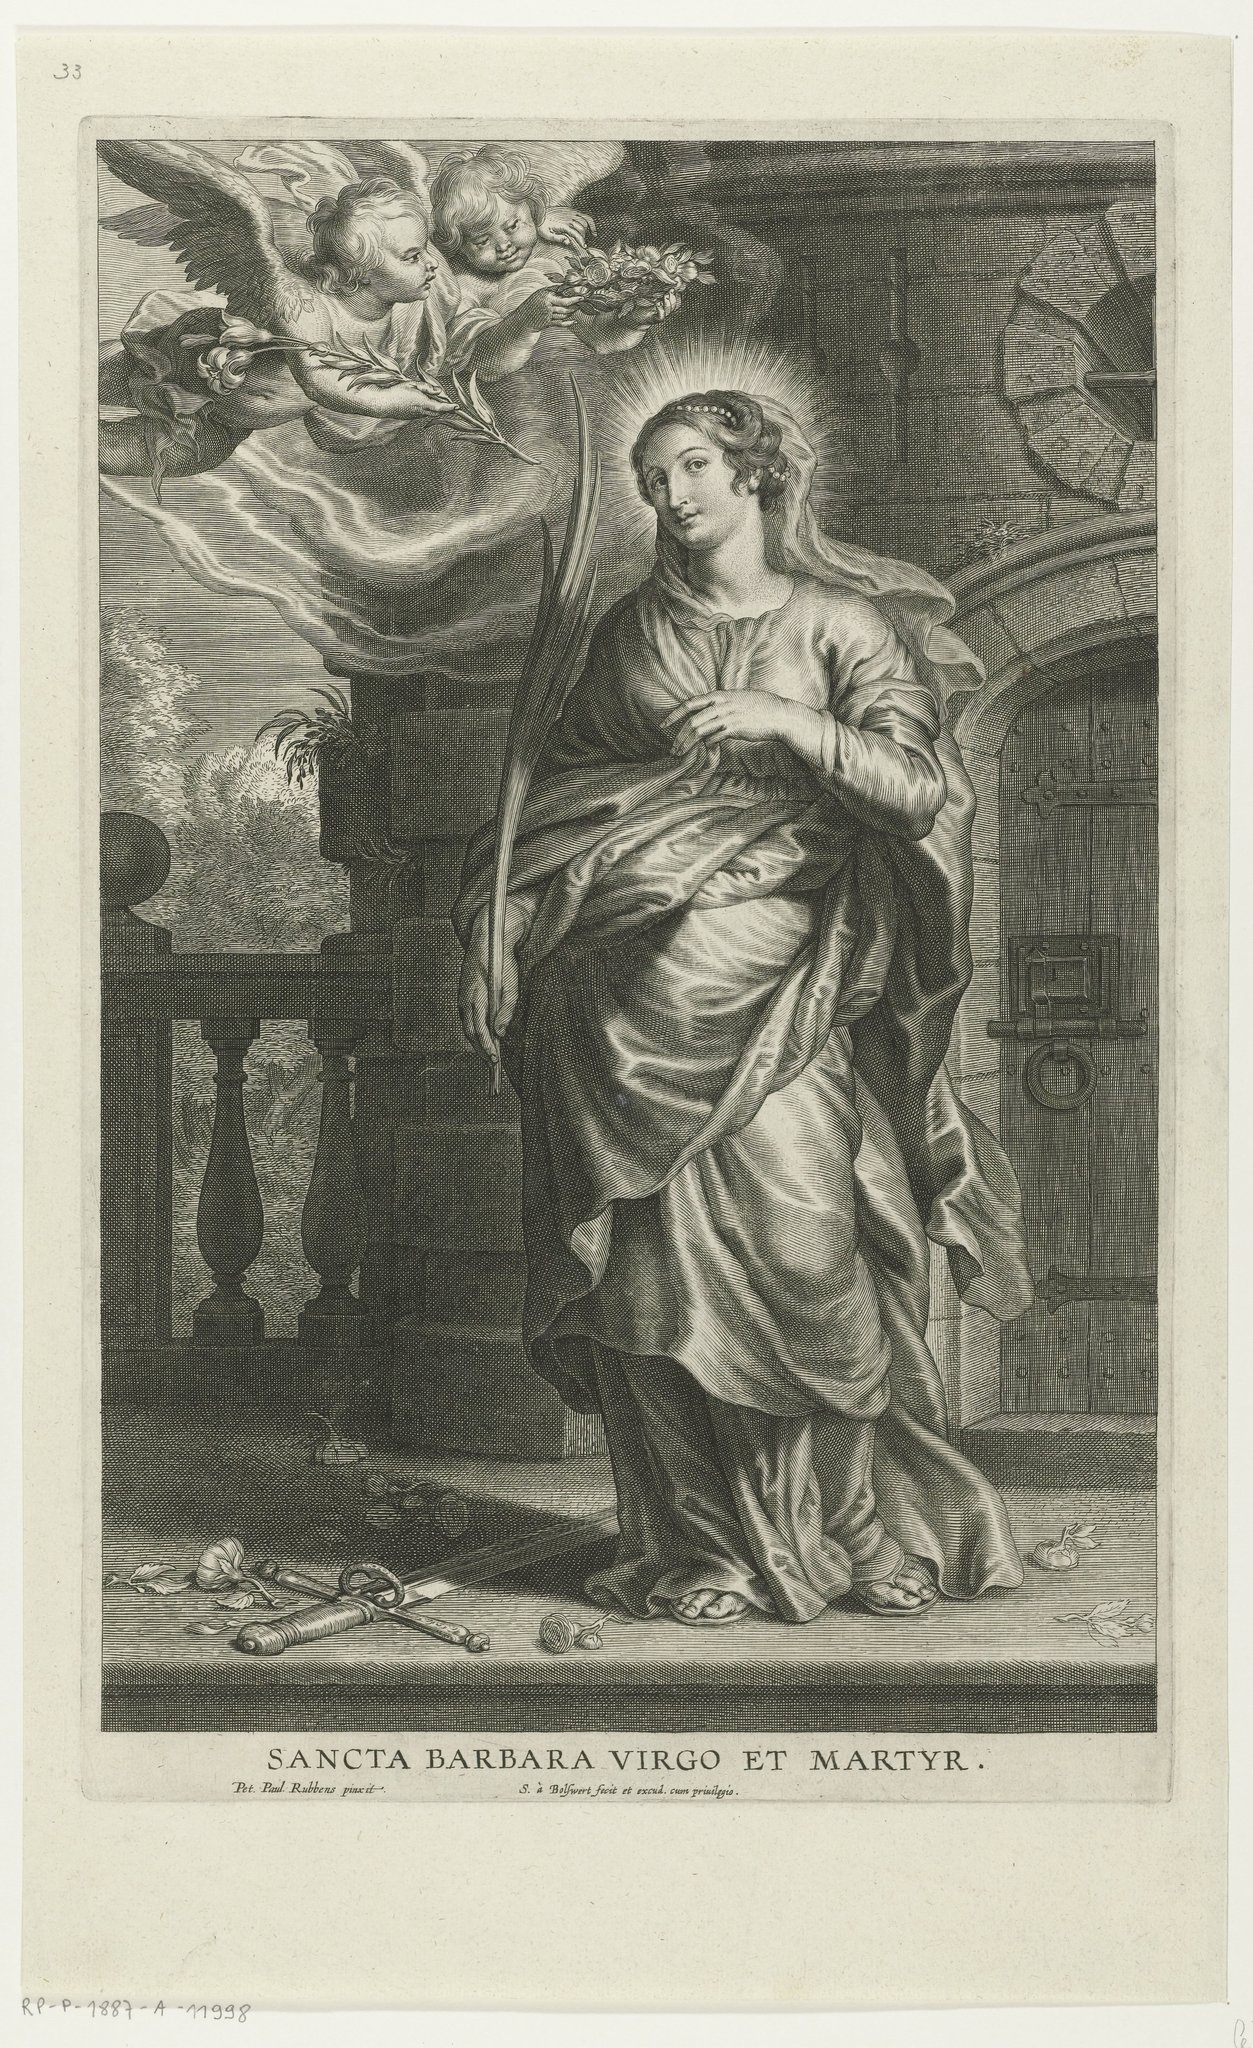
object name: print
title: Heilige Barbara als martelares met toren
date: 1596-1659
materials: paper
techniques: engraving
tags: the virgin martyr barbara; possible attributes: book, cannon(ball), crown, cross, chalice with wafer, dioscuros (her father), peacock feather, sword, torches, mason's tools, tower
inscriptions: collector's mark: Lugt 2228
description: Prent naar schilderij van Peter Paul Rubens.